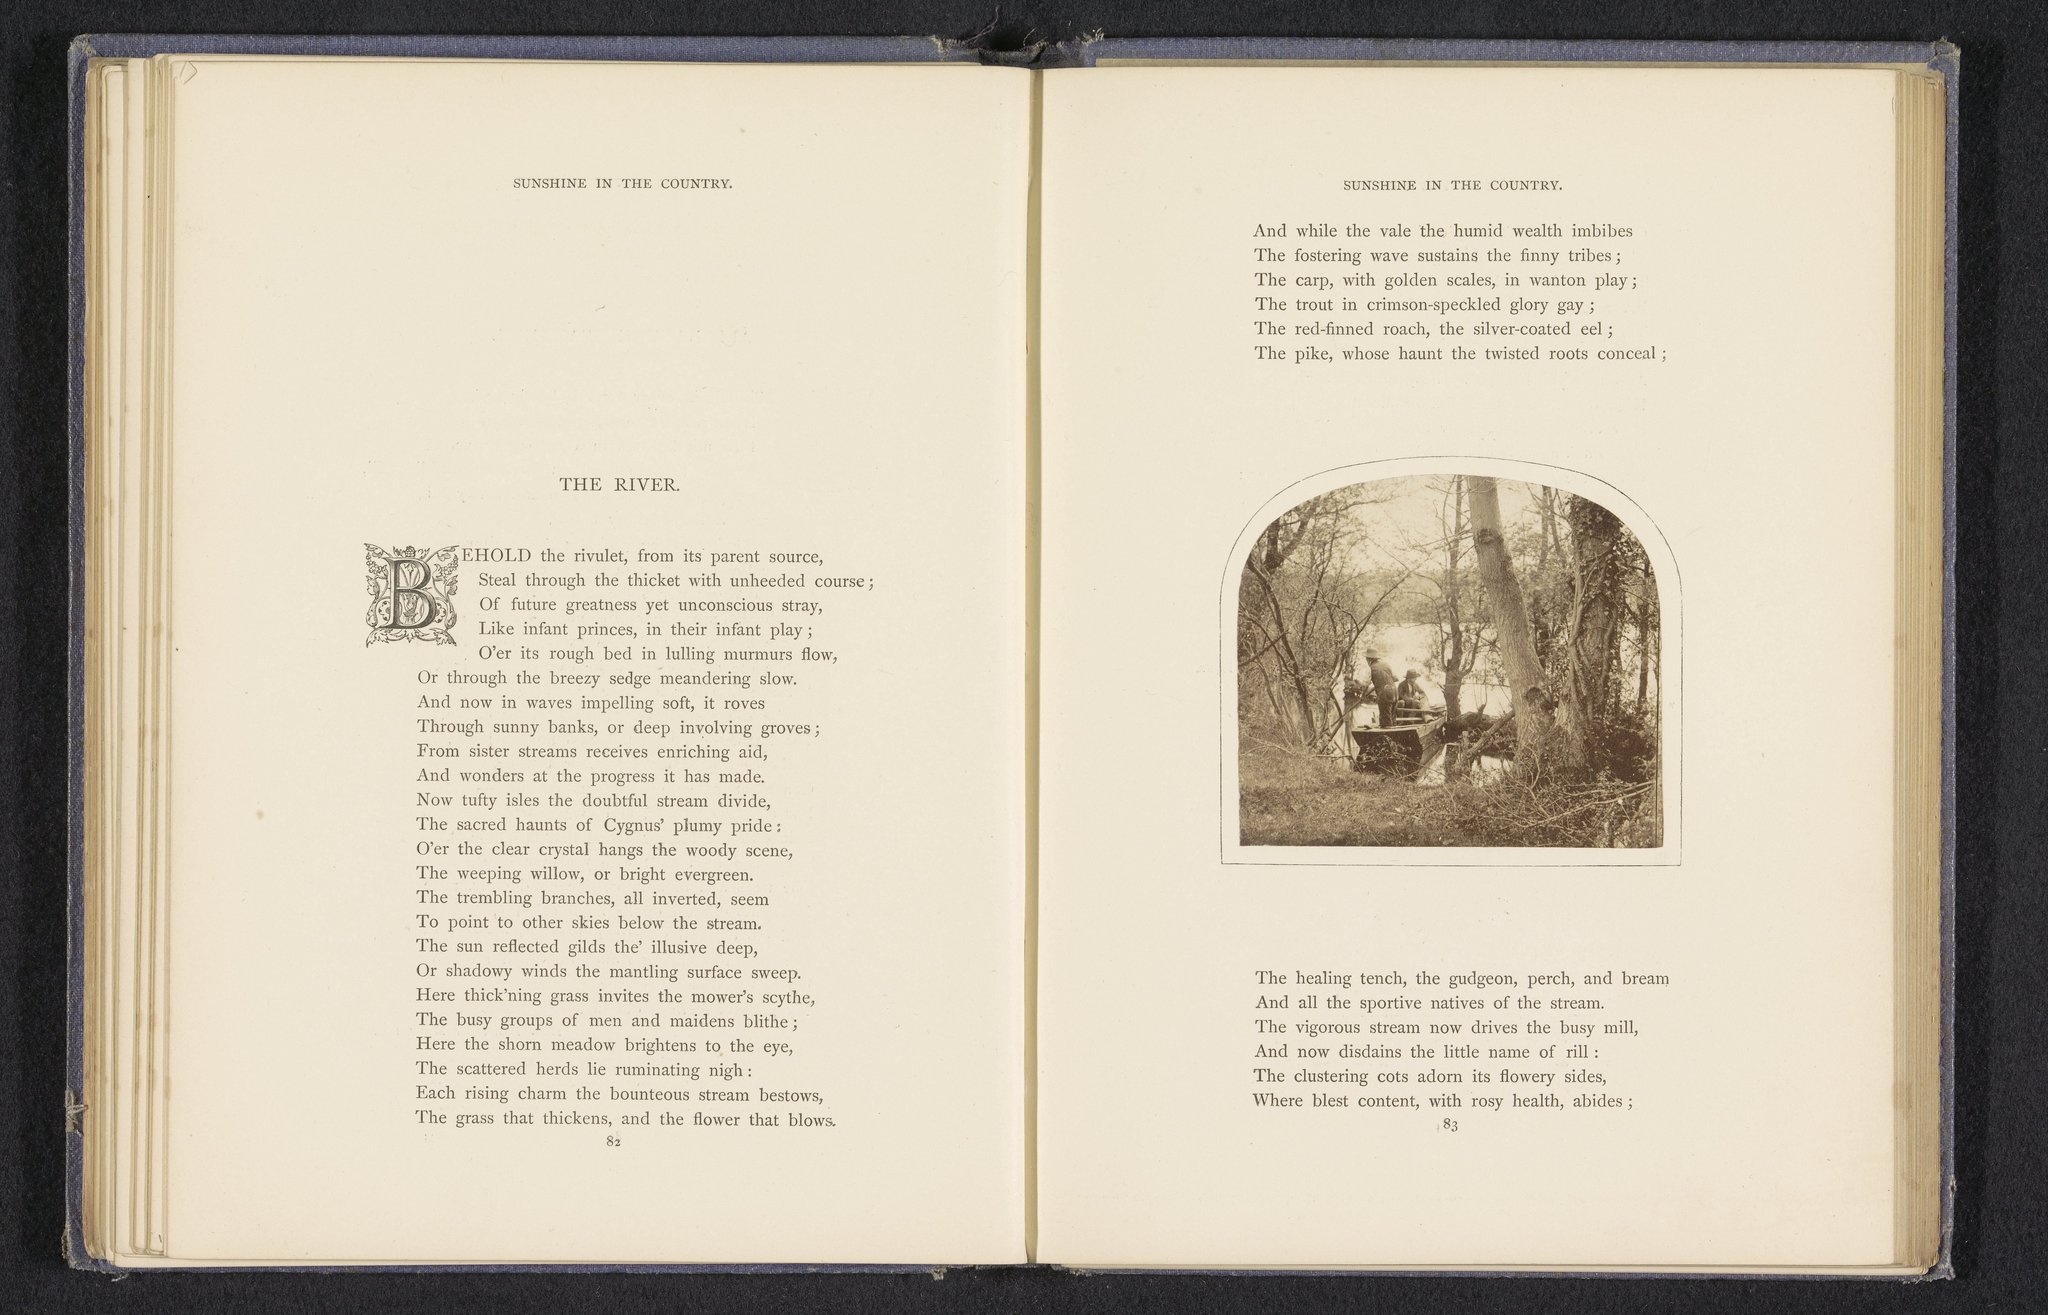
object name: photograph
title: Twee mannen in een roeiboot bij een oever met bomen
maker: william morris grundy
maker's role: fotograaf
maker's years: 1806-1859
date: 1851-1861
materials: photographic support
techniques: albumen print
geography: england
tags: rowing-boat, canoe, etc.